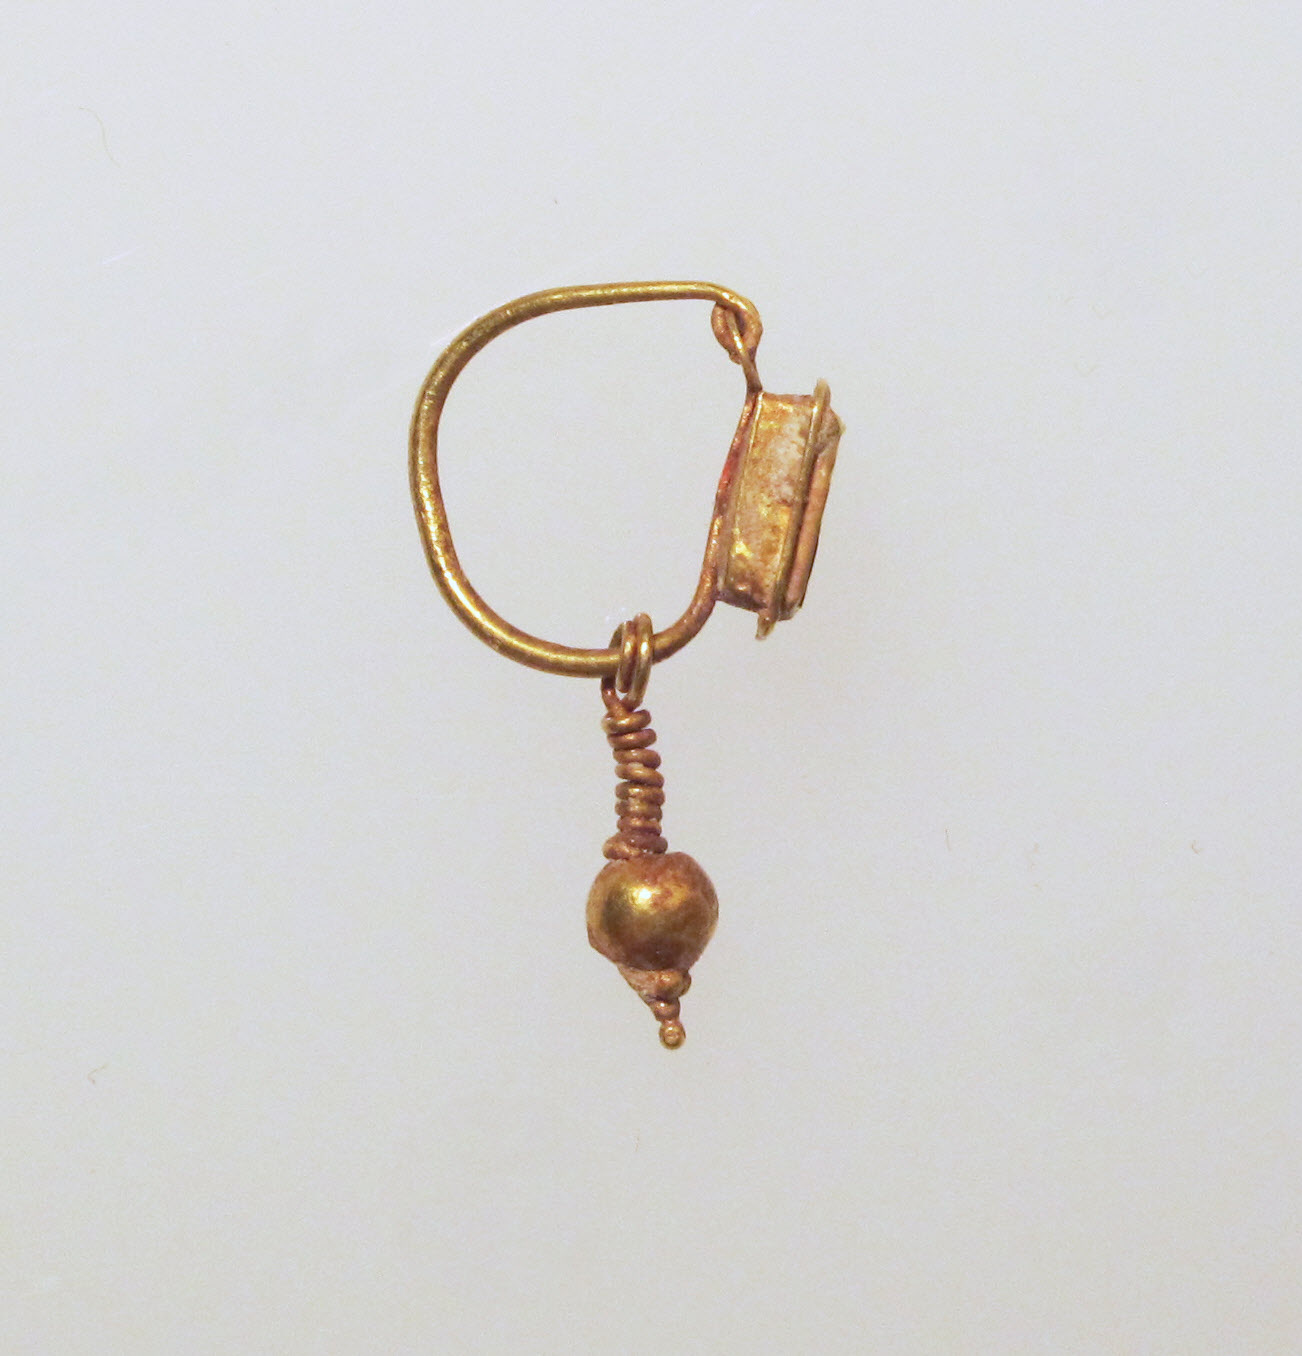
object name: earring hook type with ball pendant and paste setting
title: Earring with ball pendant and paste setting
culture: roman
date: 1-200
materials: glass, gold, paste